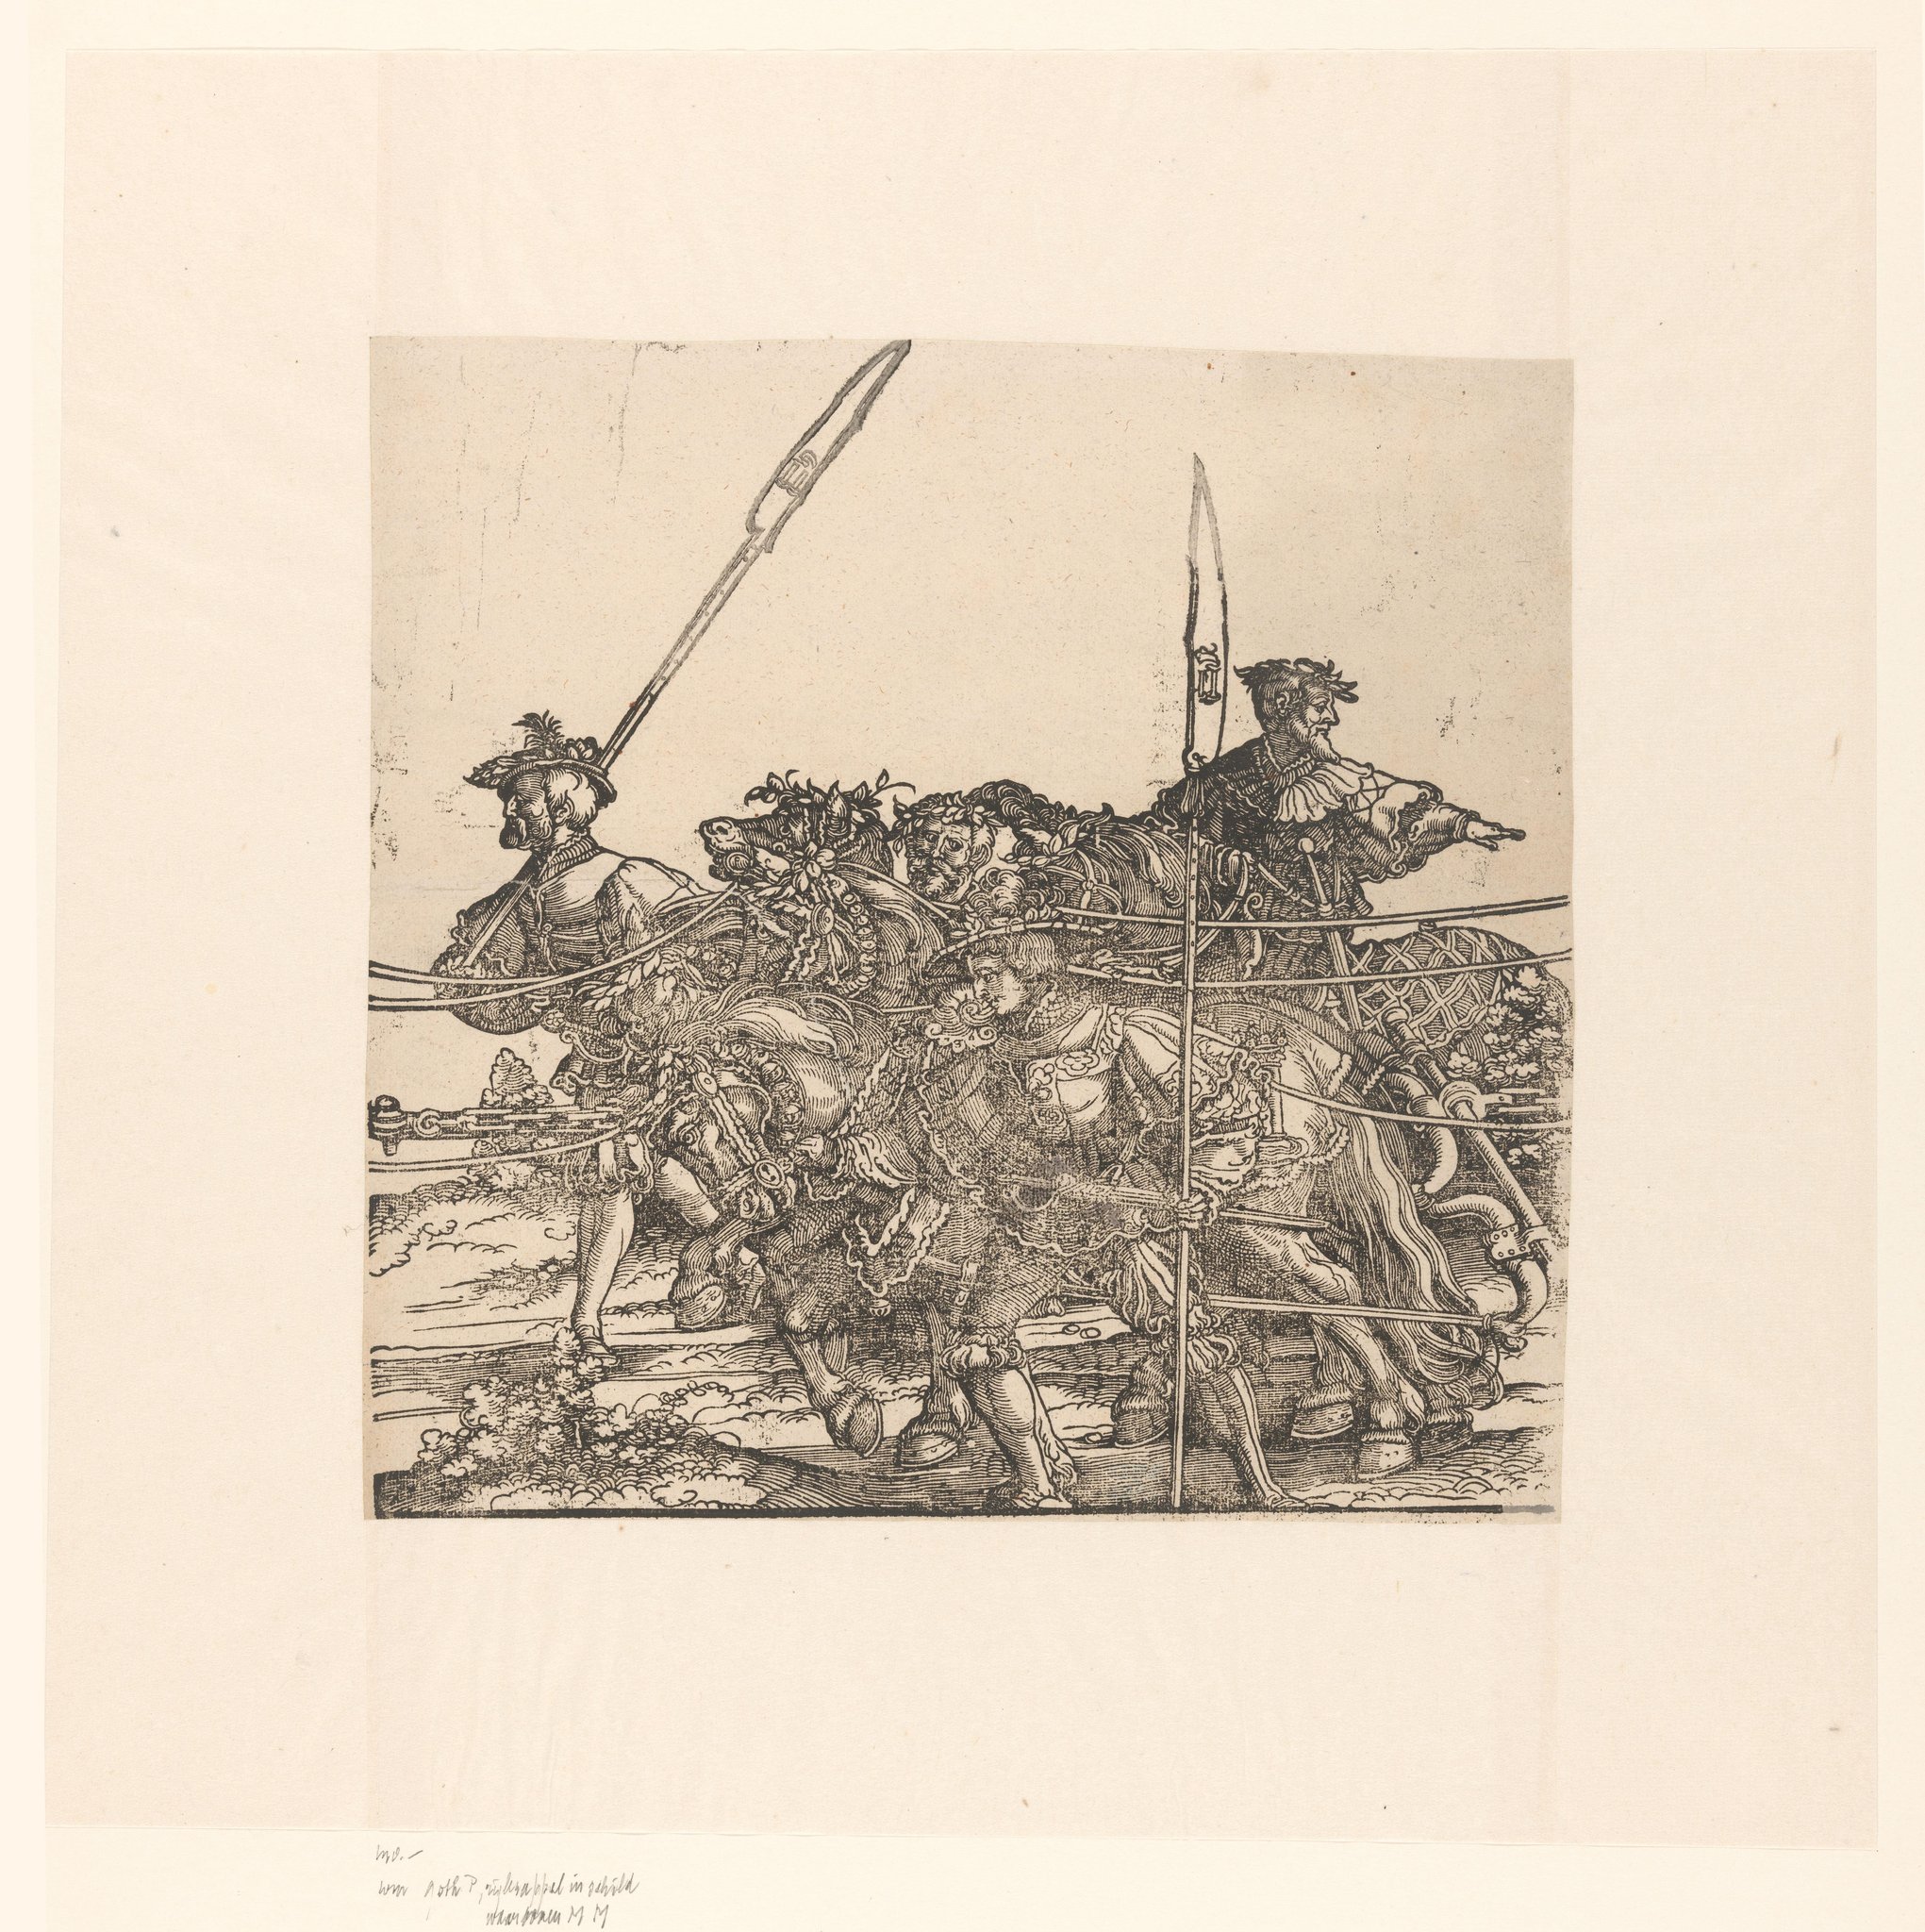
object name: print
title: Triomfwagen van Karel V, 1537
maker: hans schäufelein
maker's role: print maker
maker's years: 1480-1540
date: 1537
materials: paper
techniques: woodcut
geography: germany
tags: ghent, charles v (holy roman emperor and king of spain), chariot, triumphal car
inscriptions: collector's mark: Lugt 2228, collector's mark: Lugt 2166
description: Serie van 9 houtsneden van de triomfwagen van keizer Karel V die aan elkaar tot een doorlopend fries gemonteerd kunnen worden. De teksten boven de voorstellingen ontbreken in deze druk. Uitgave van deze tweede staat van de blokken is volgens German Hollstein (dl. XLII, p. 126) te dateren ca. 1537-1551. De watermerken van deze afdrukken wijzen op een latere datering ca. 1580-1616. De prenten worden hier beschreven naar de volgorde in Bartsch, een andere volgende dan in Hollstein en Geisberg staat, namelijk met de platen Hollstein German 51 en 52 (de plaat met het impressum) niet als de derde en vierde platen maar als achtste en negende (voorlaatste en laatste).